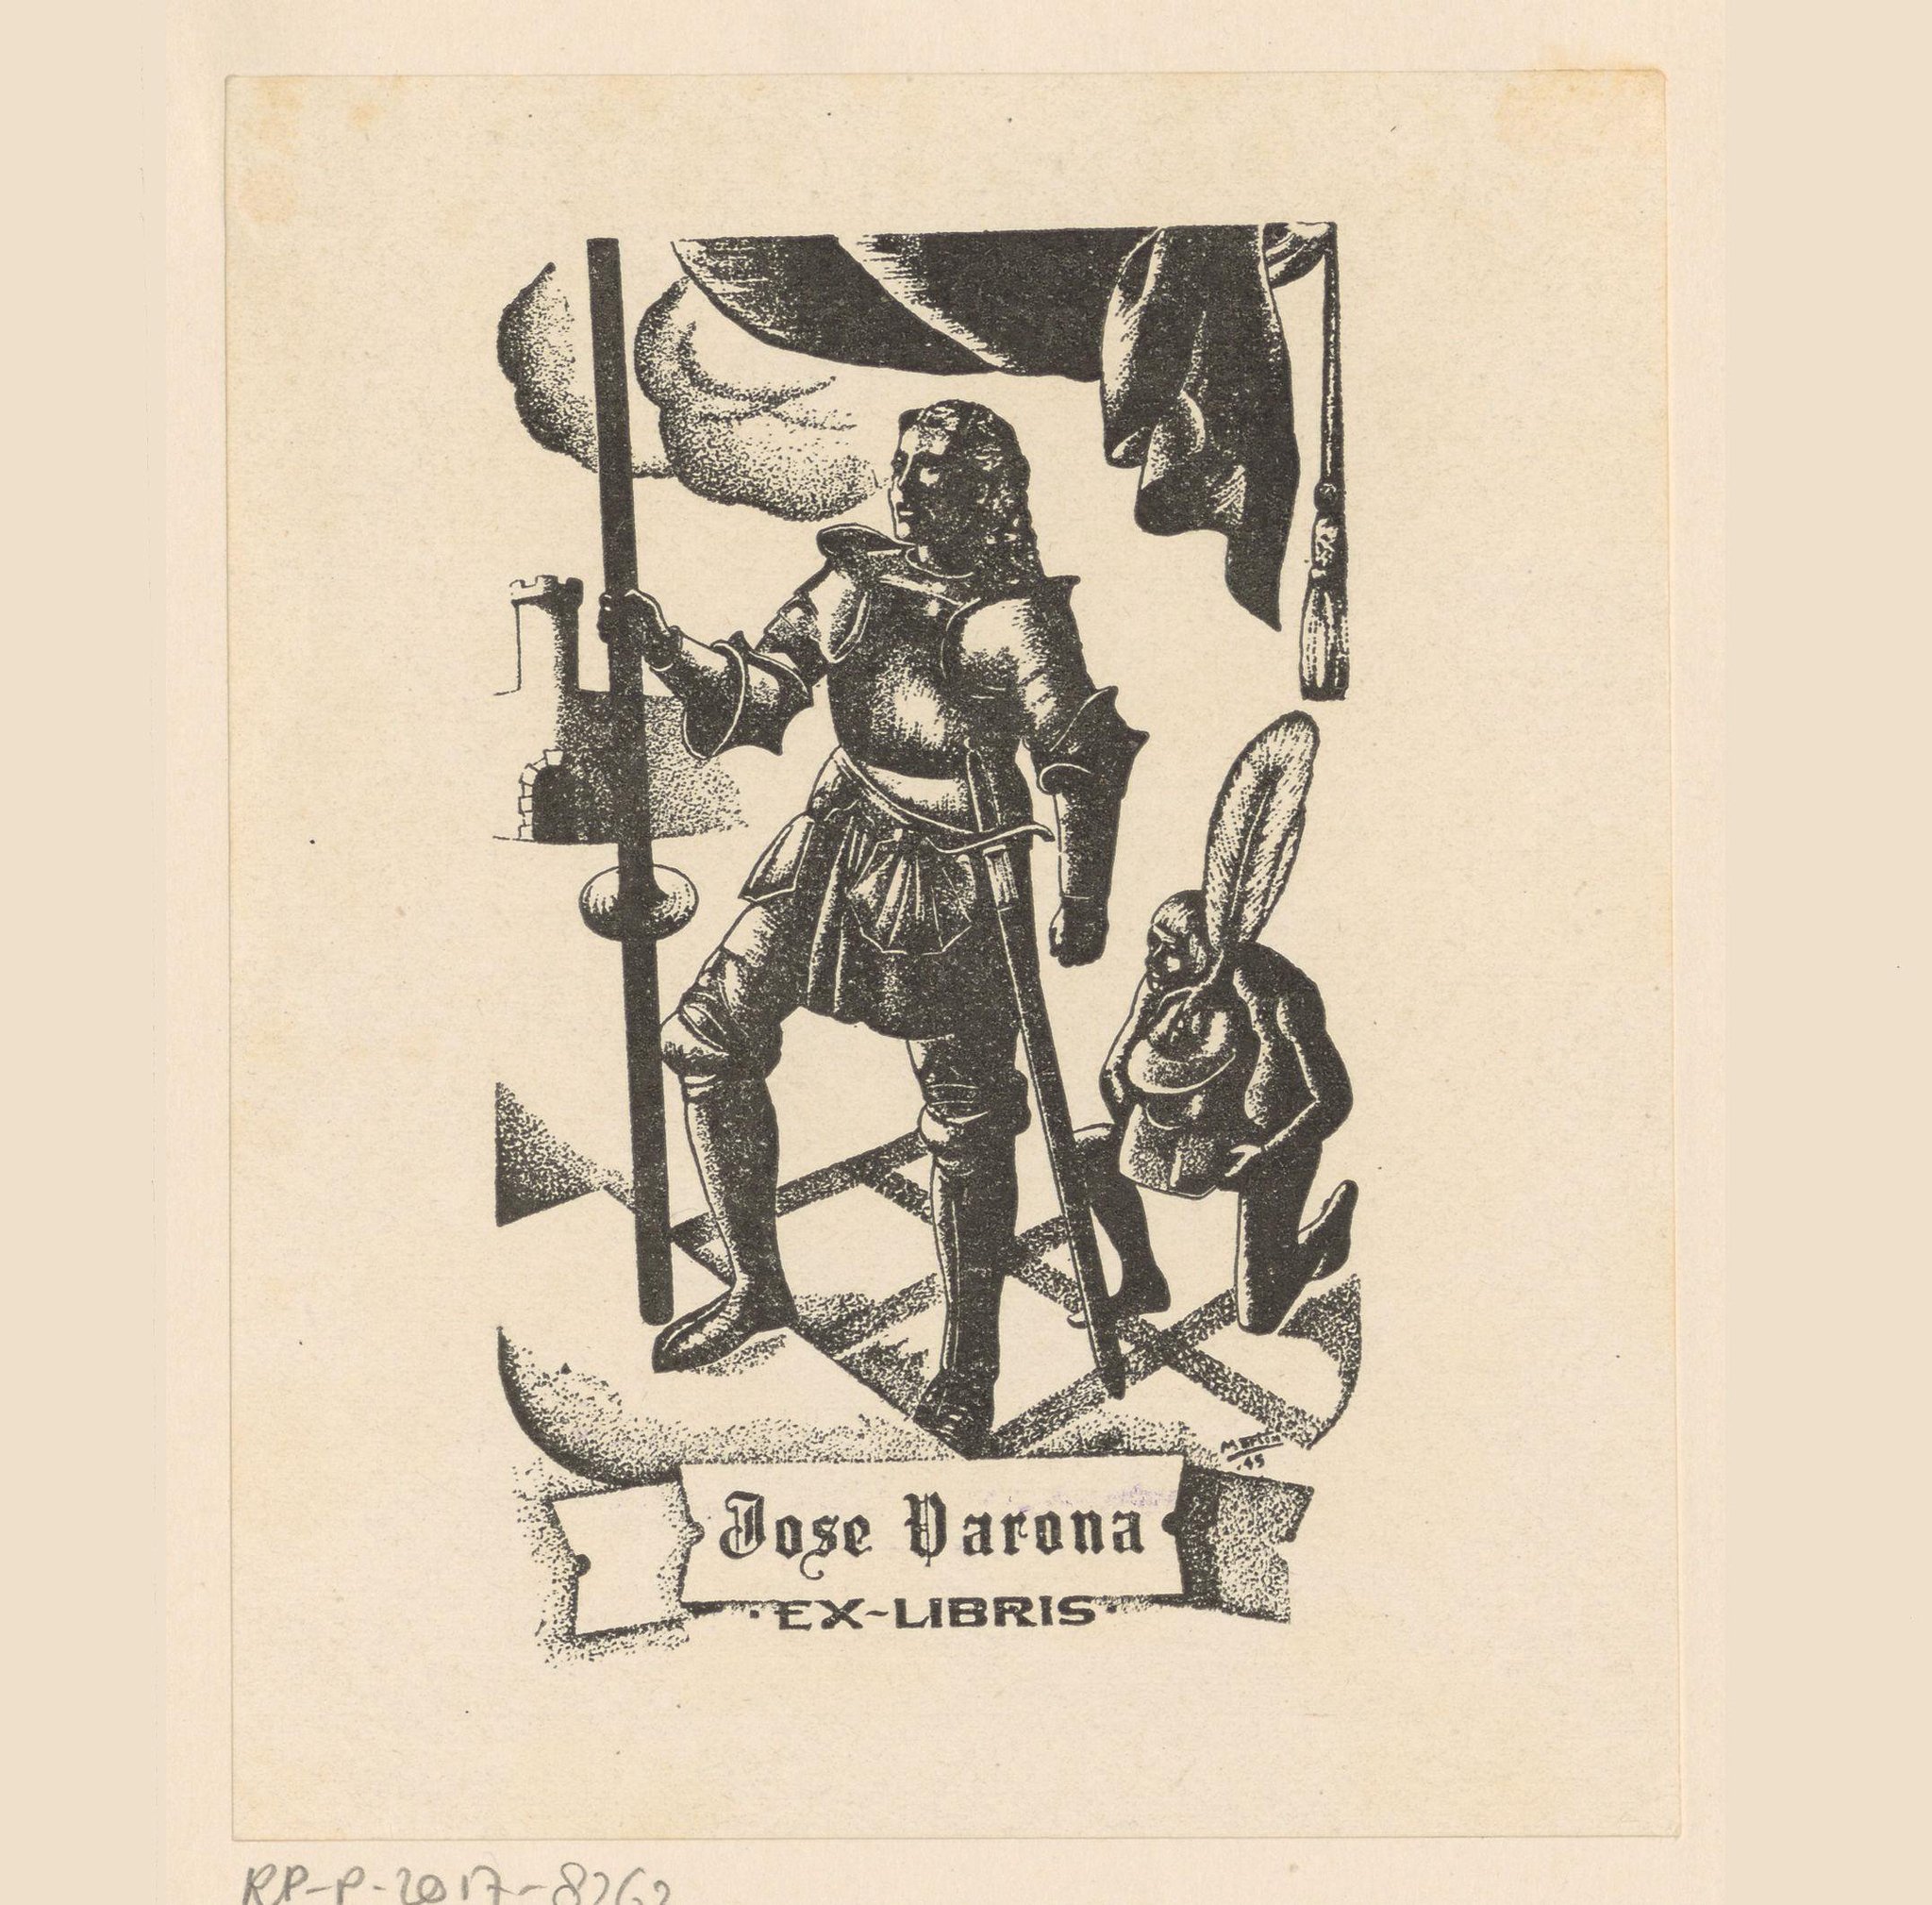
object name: bookplate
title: Ex libris van José Varona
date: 1945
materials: paper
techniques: printing block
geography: spain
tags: armour, joan of arc (jeanne d'arc); possible attributes: armour, banner, lance, sword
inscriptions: stamp: ‘José Varona Santillán/ héroes del Alcázar, 4. hab, 24/ Burgos’